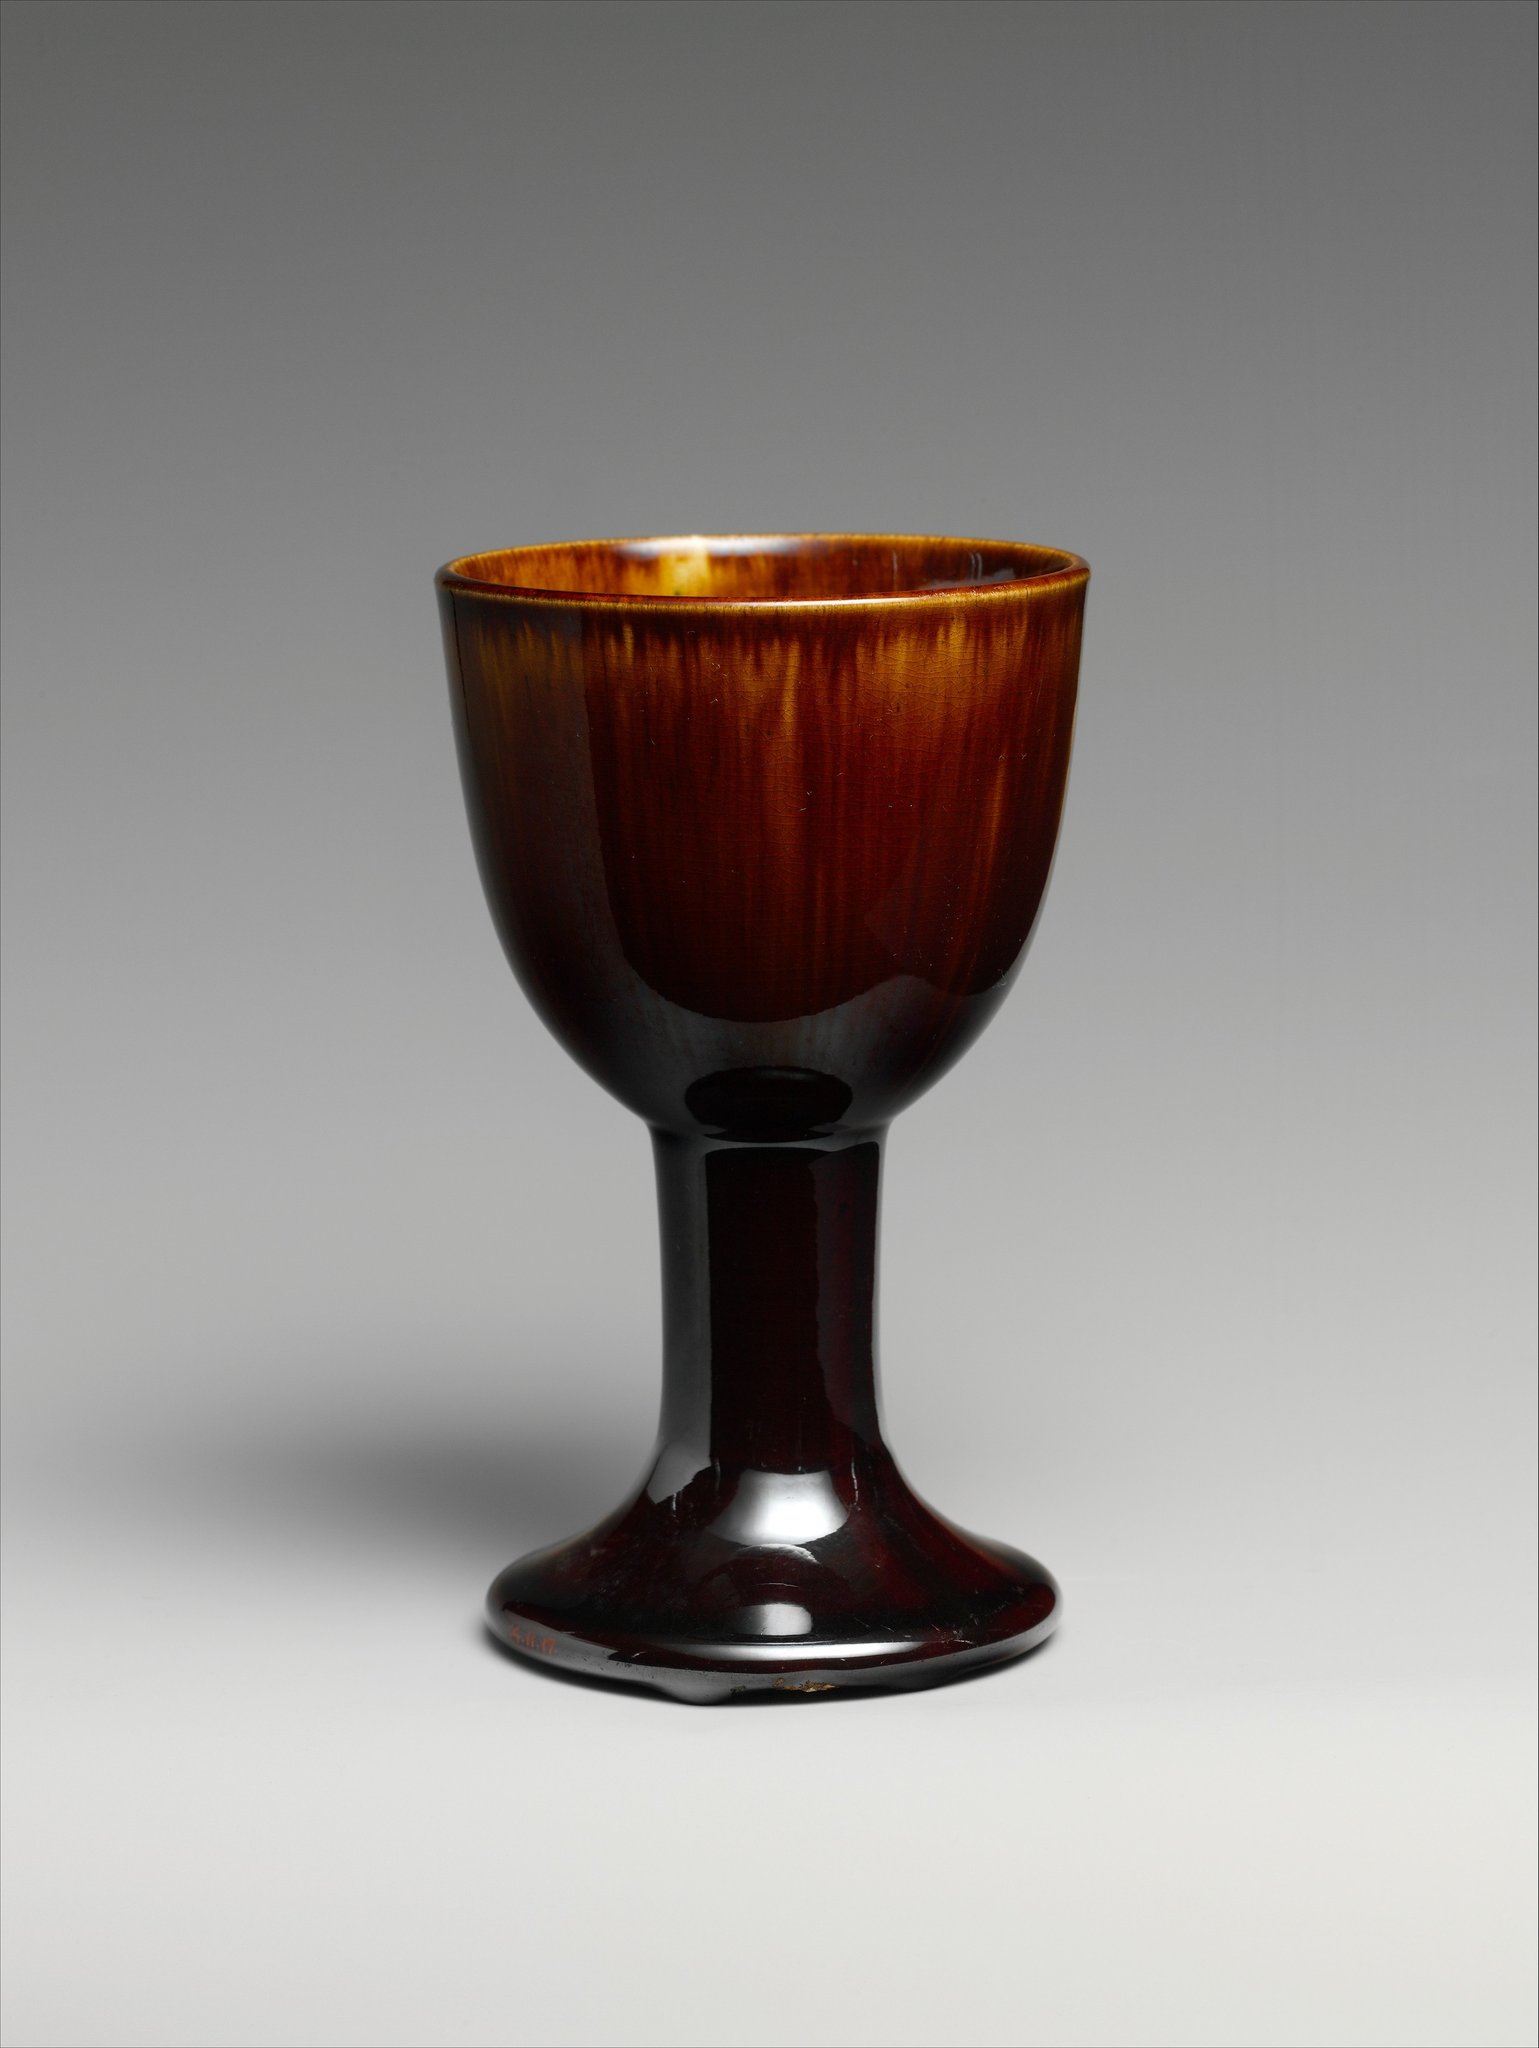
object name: goblet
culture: american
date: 1830-1870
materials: earthenware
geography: united states